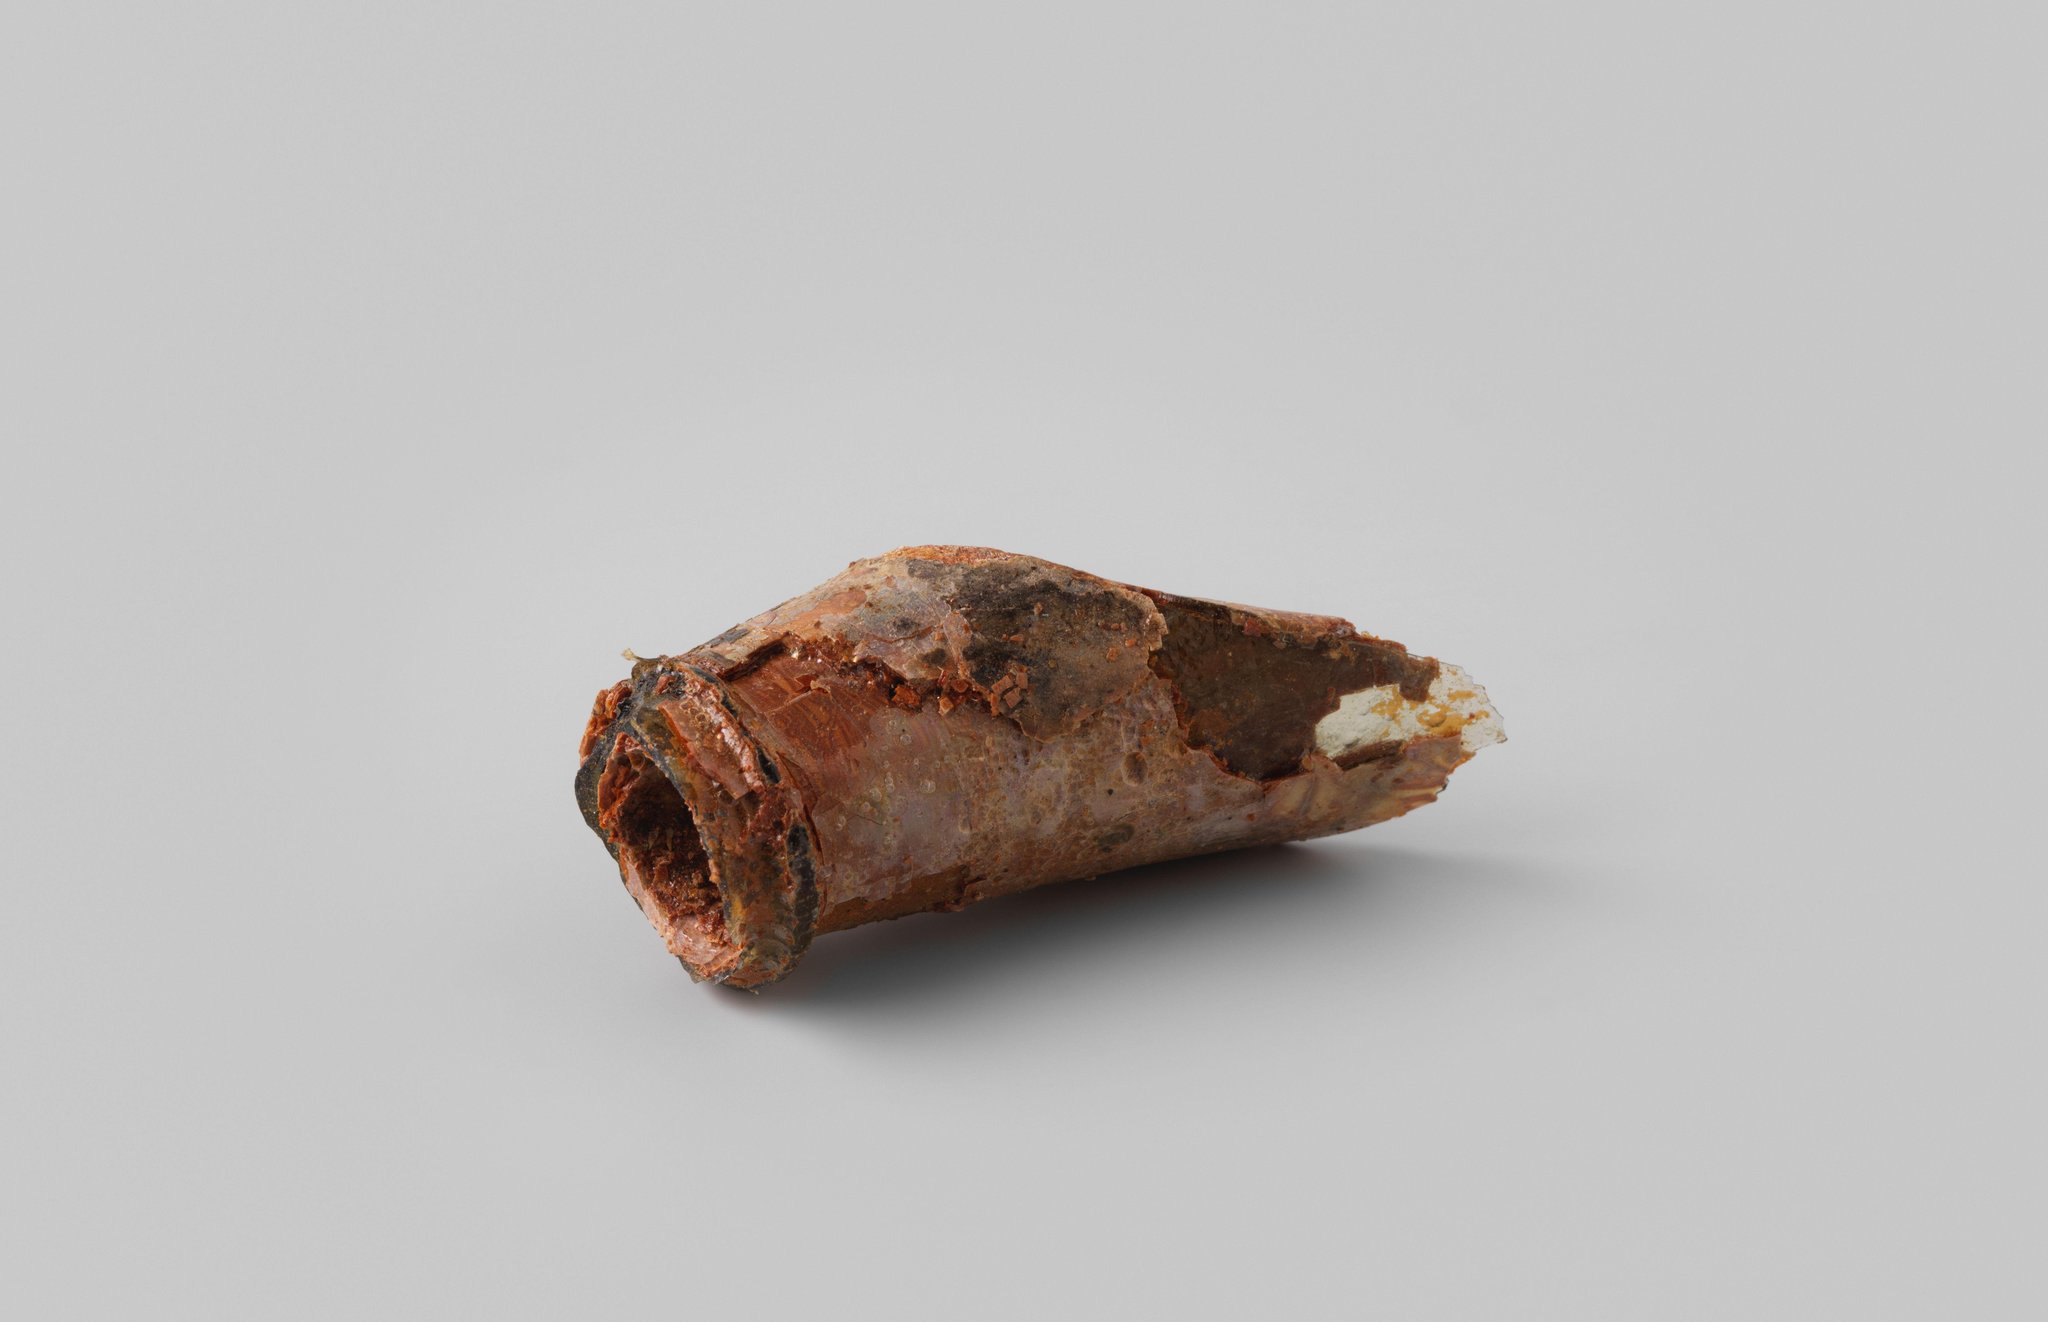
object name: wine bottle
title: Hals van een wijnfles uit het wrak van de Oost-Indiëvaarder Hollandia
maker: Anonymous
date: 1700-1743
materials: glass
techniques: green glass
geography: netherlands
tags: verenigde oostindische compagnie, hollandia (schip), annet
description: Wine bottle, continental production, neck, onion-shaped bottle or bottle with vertical side; fragm, eroded, f-string rim.